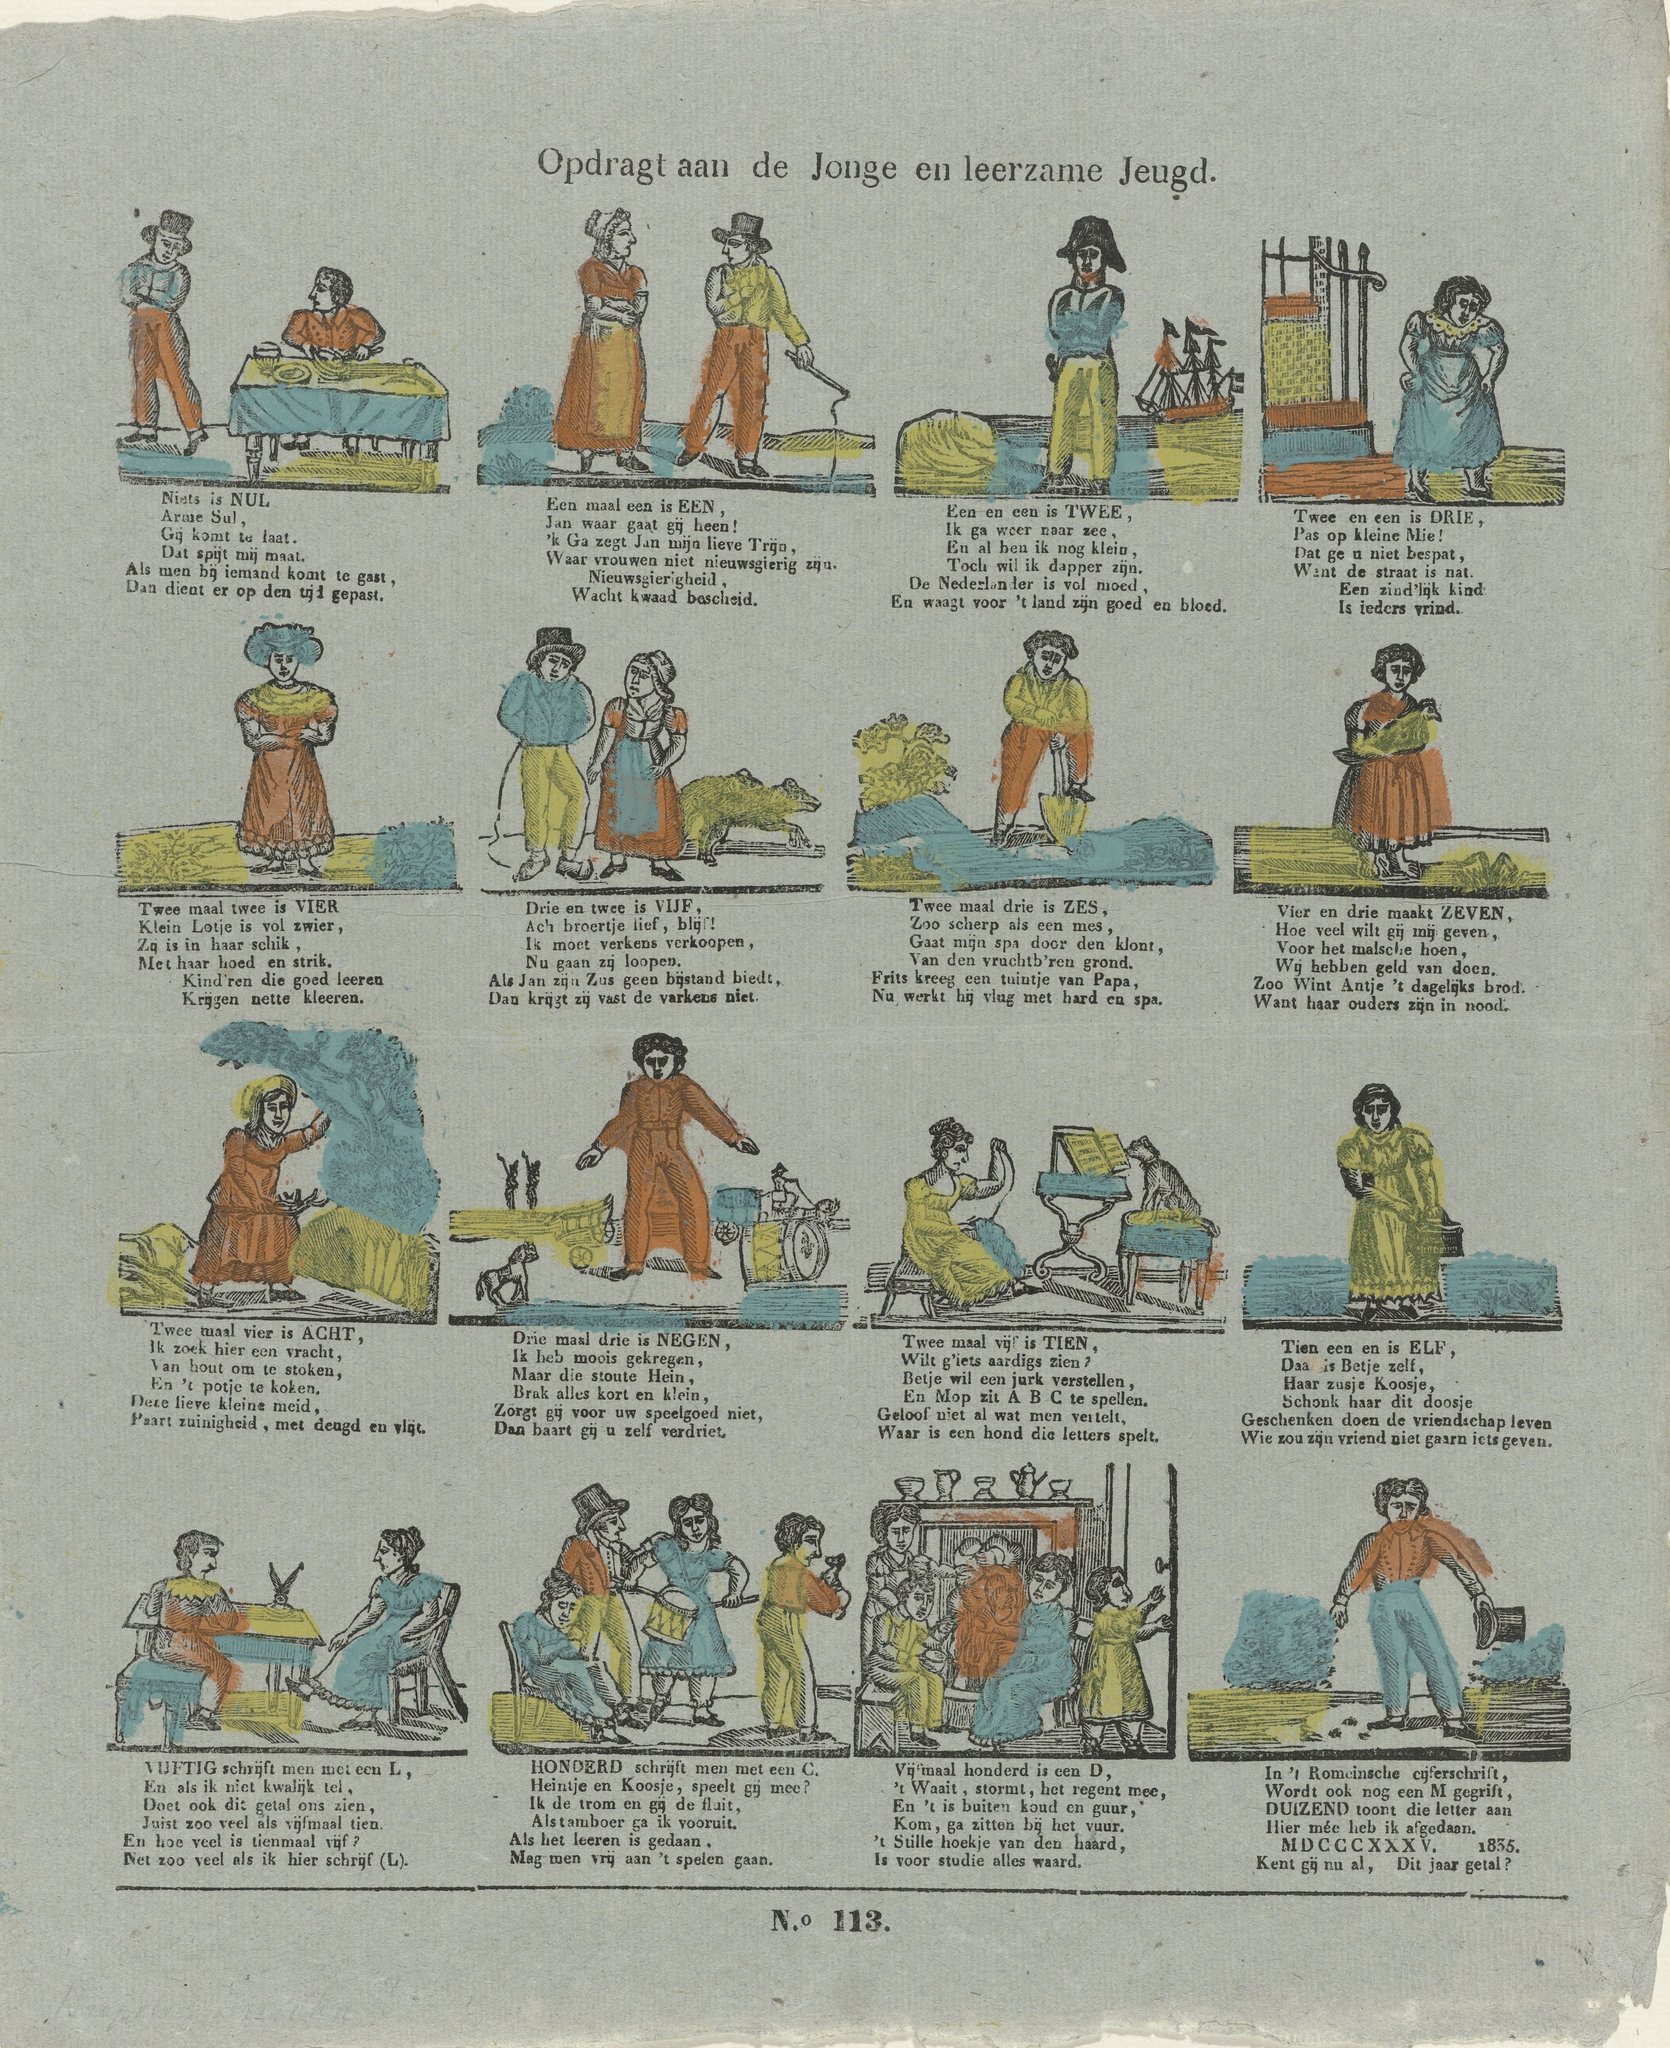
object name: print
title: Opdragt aan de jonge en leerzame jeugd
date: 1800-1833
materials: paper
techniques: colour, letterpress printing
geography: turnhout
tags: counting, calculating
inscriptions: collector's mark: Lugt 2760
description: Blad met 16 voorstellingen van verschillende aard met versjes over rekenen (rekenles). Genummerd midden onder: No. 113.